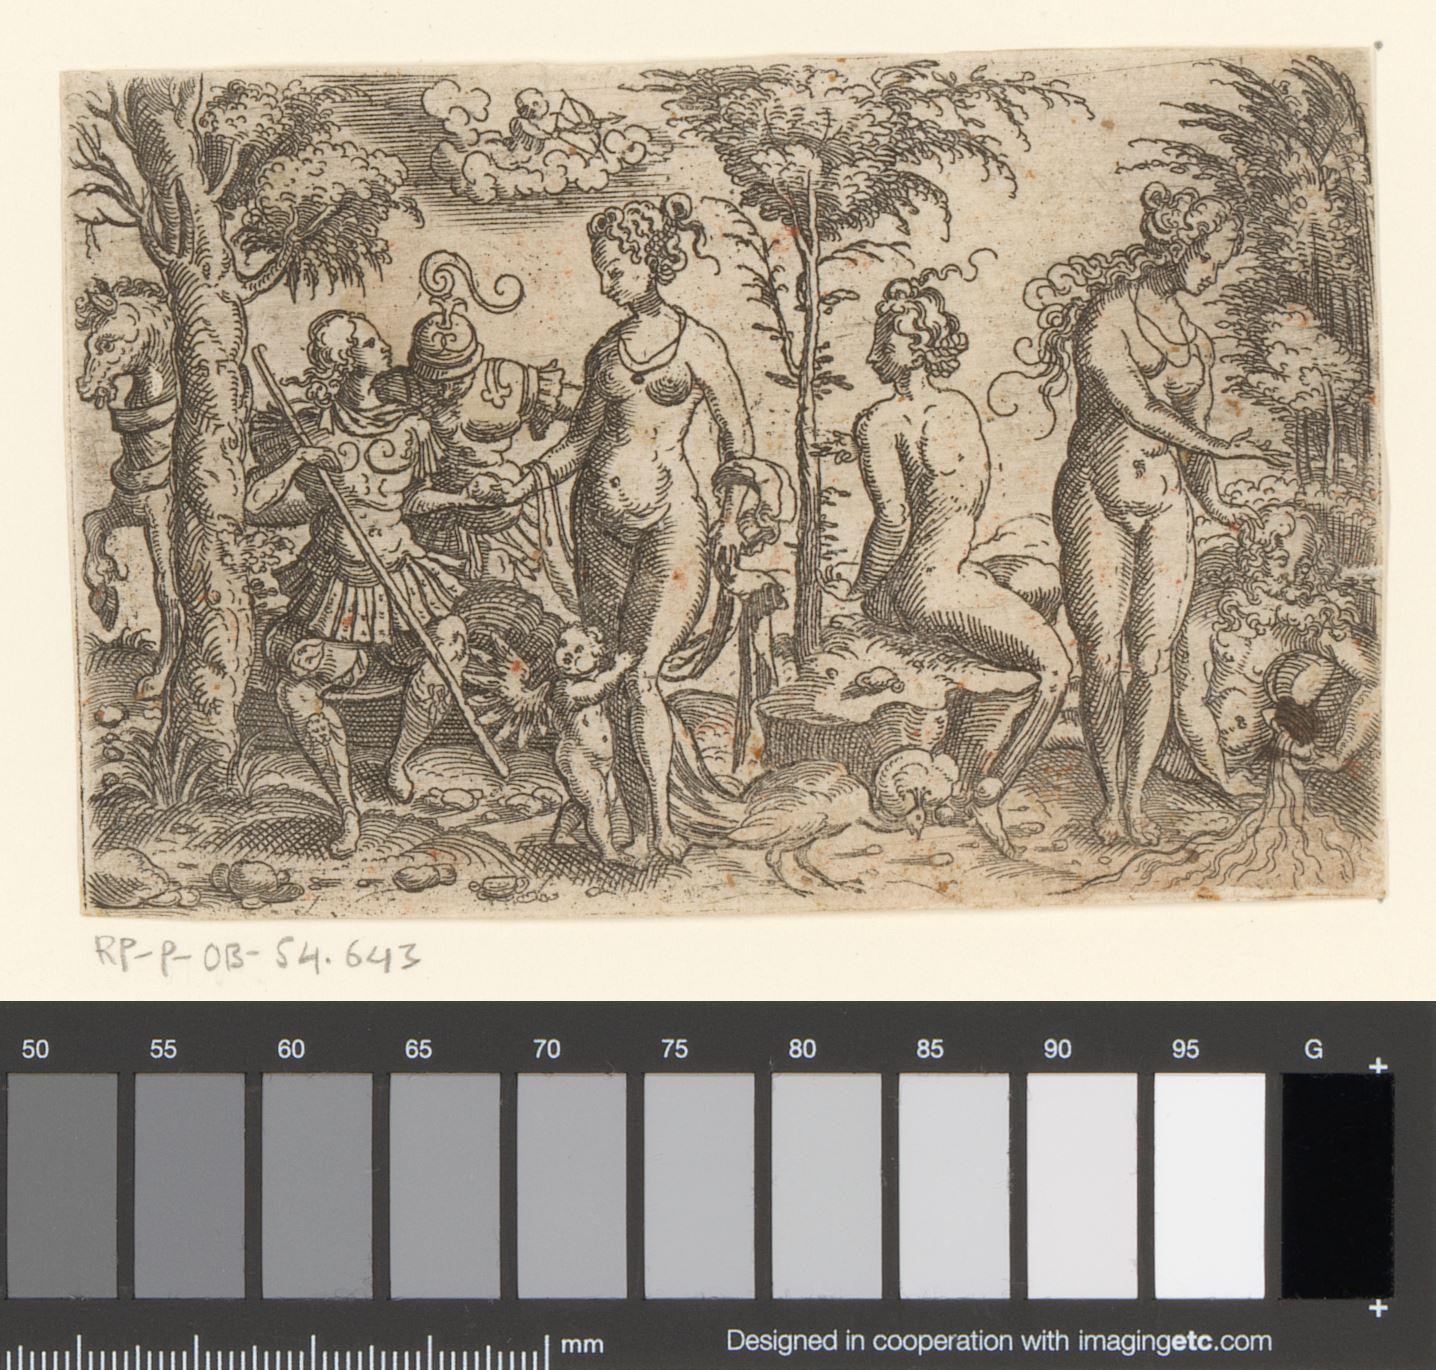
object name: print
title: Oordeel van Paris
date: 1524-1562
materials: ink, paper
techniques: brush, etching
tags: the judgement of paris (without mercury)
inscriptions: collector's mark: Lugt 2228, number: ‘121’